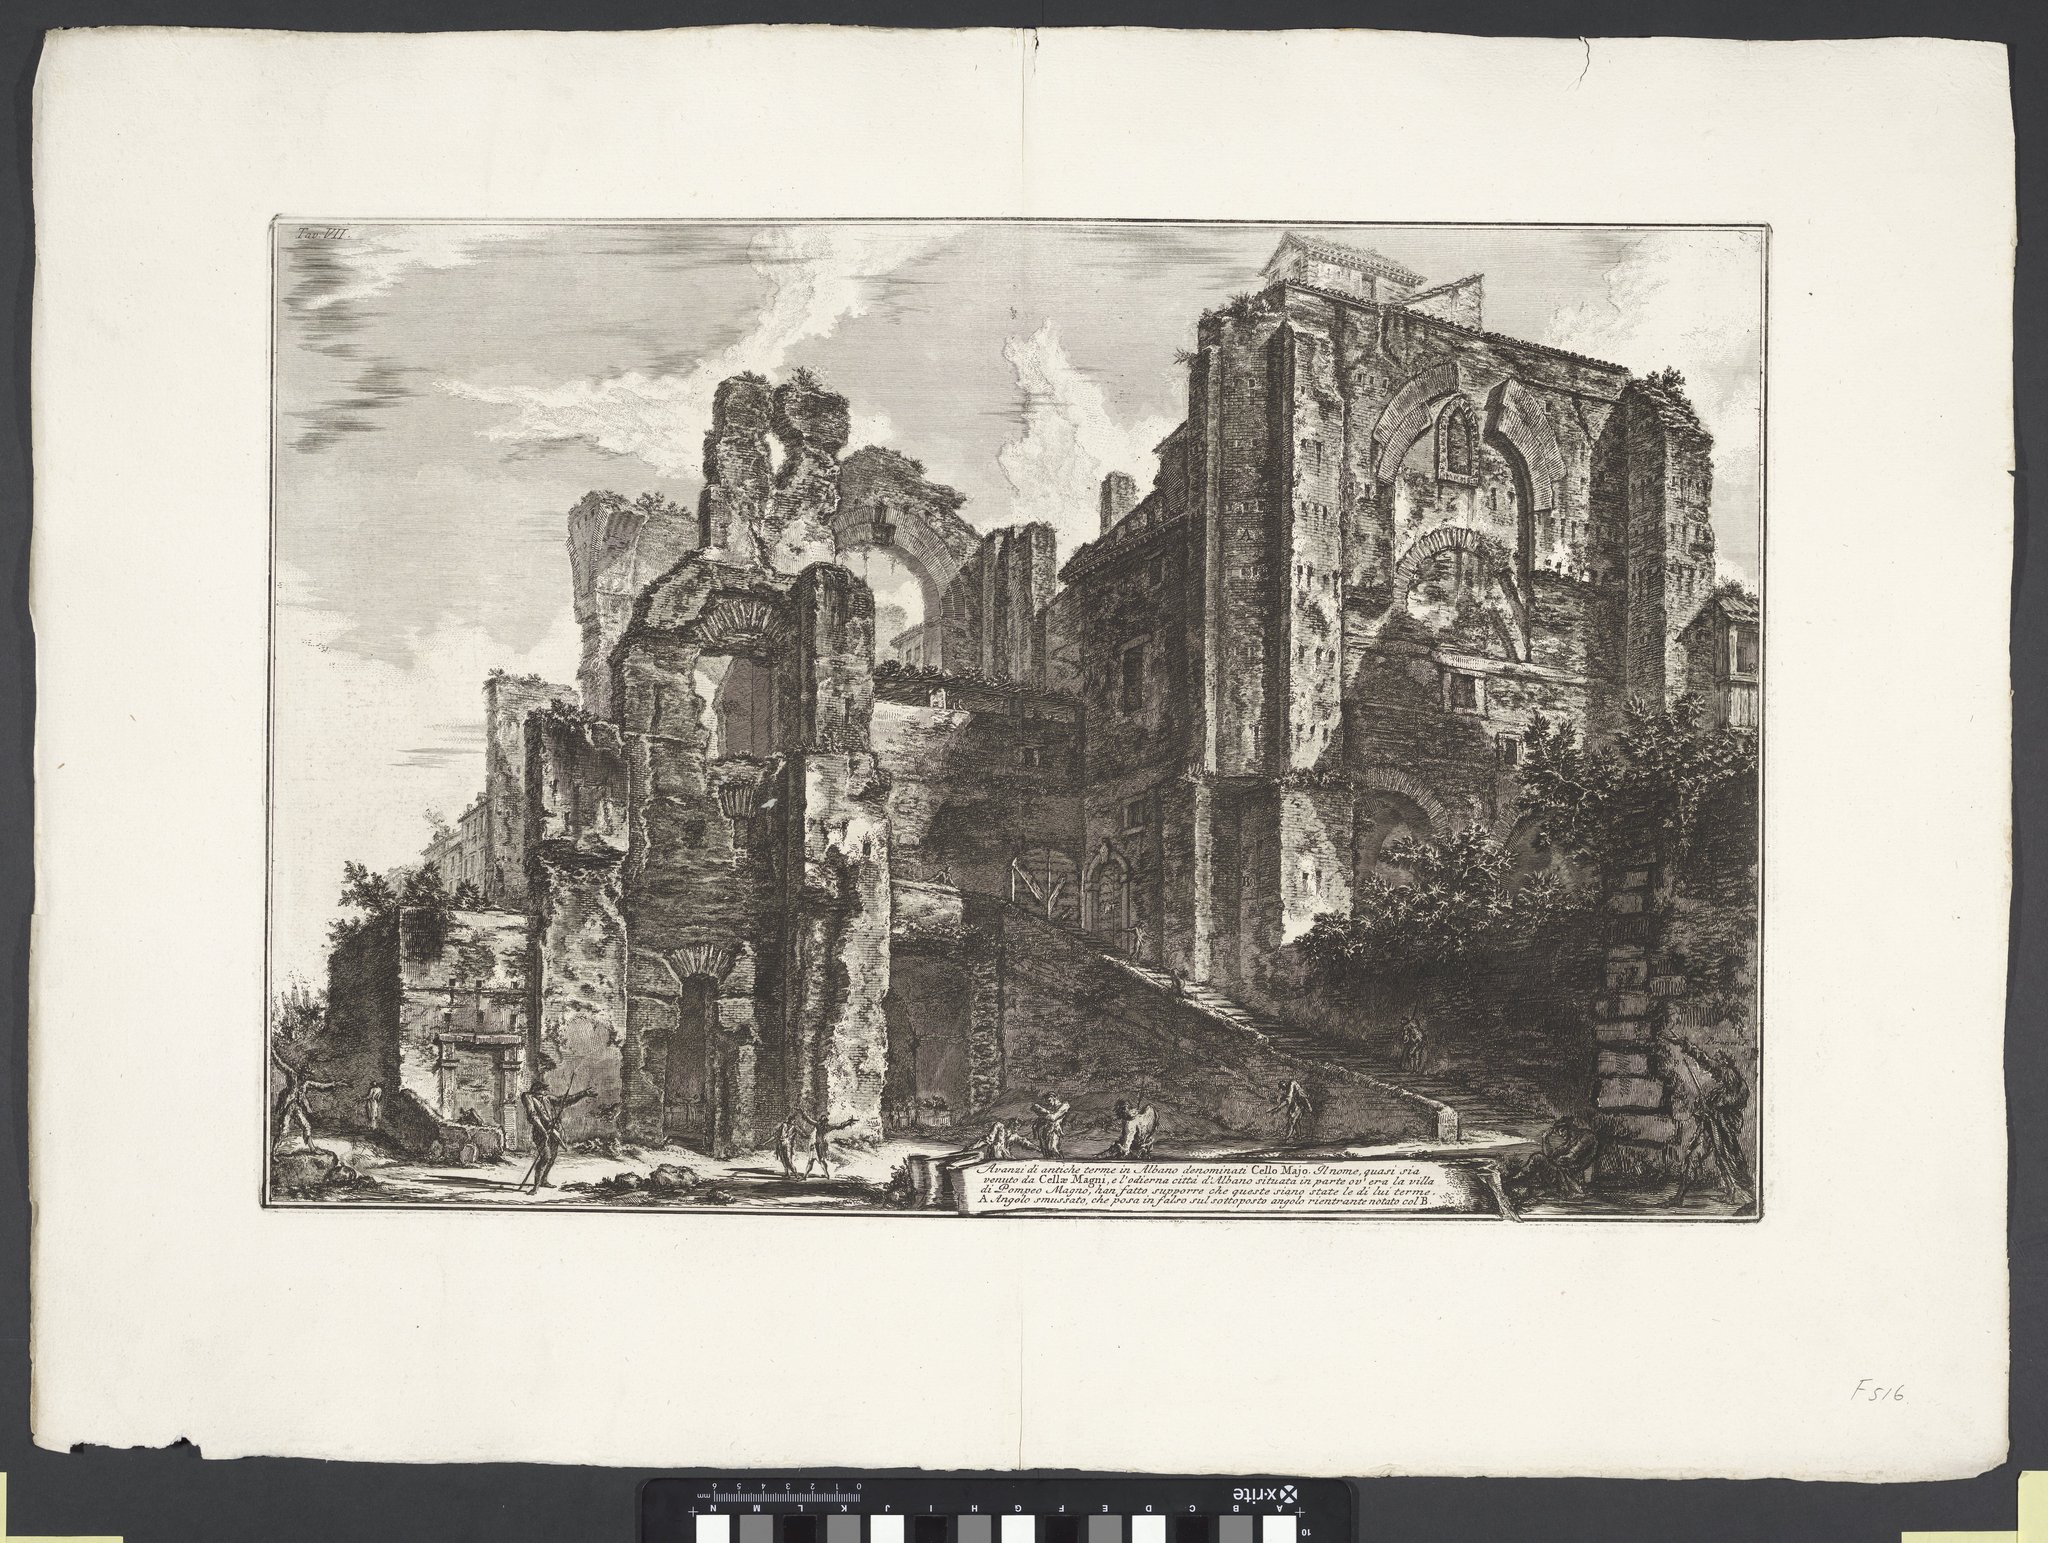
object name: print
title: Archeologische vondsten uit Albano en Castel Gandolfo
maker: giovanni battista piranesi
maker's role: designer, draughtsman, print maker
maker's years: 1720-1778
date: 1764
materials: paper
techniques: etching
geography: rome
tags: city-view, and landscape with man-made constructions, ruin of a building ~ architecture, landscape with ruins, public baths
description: Deze prent maakt deel uit van de serie van 33 prenten (inclusief titelprent, opdracht, vignet en ornamentele letter) met de titel 'Antichità d'Albano e di Castel Gandolfo'.